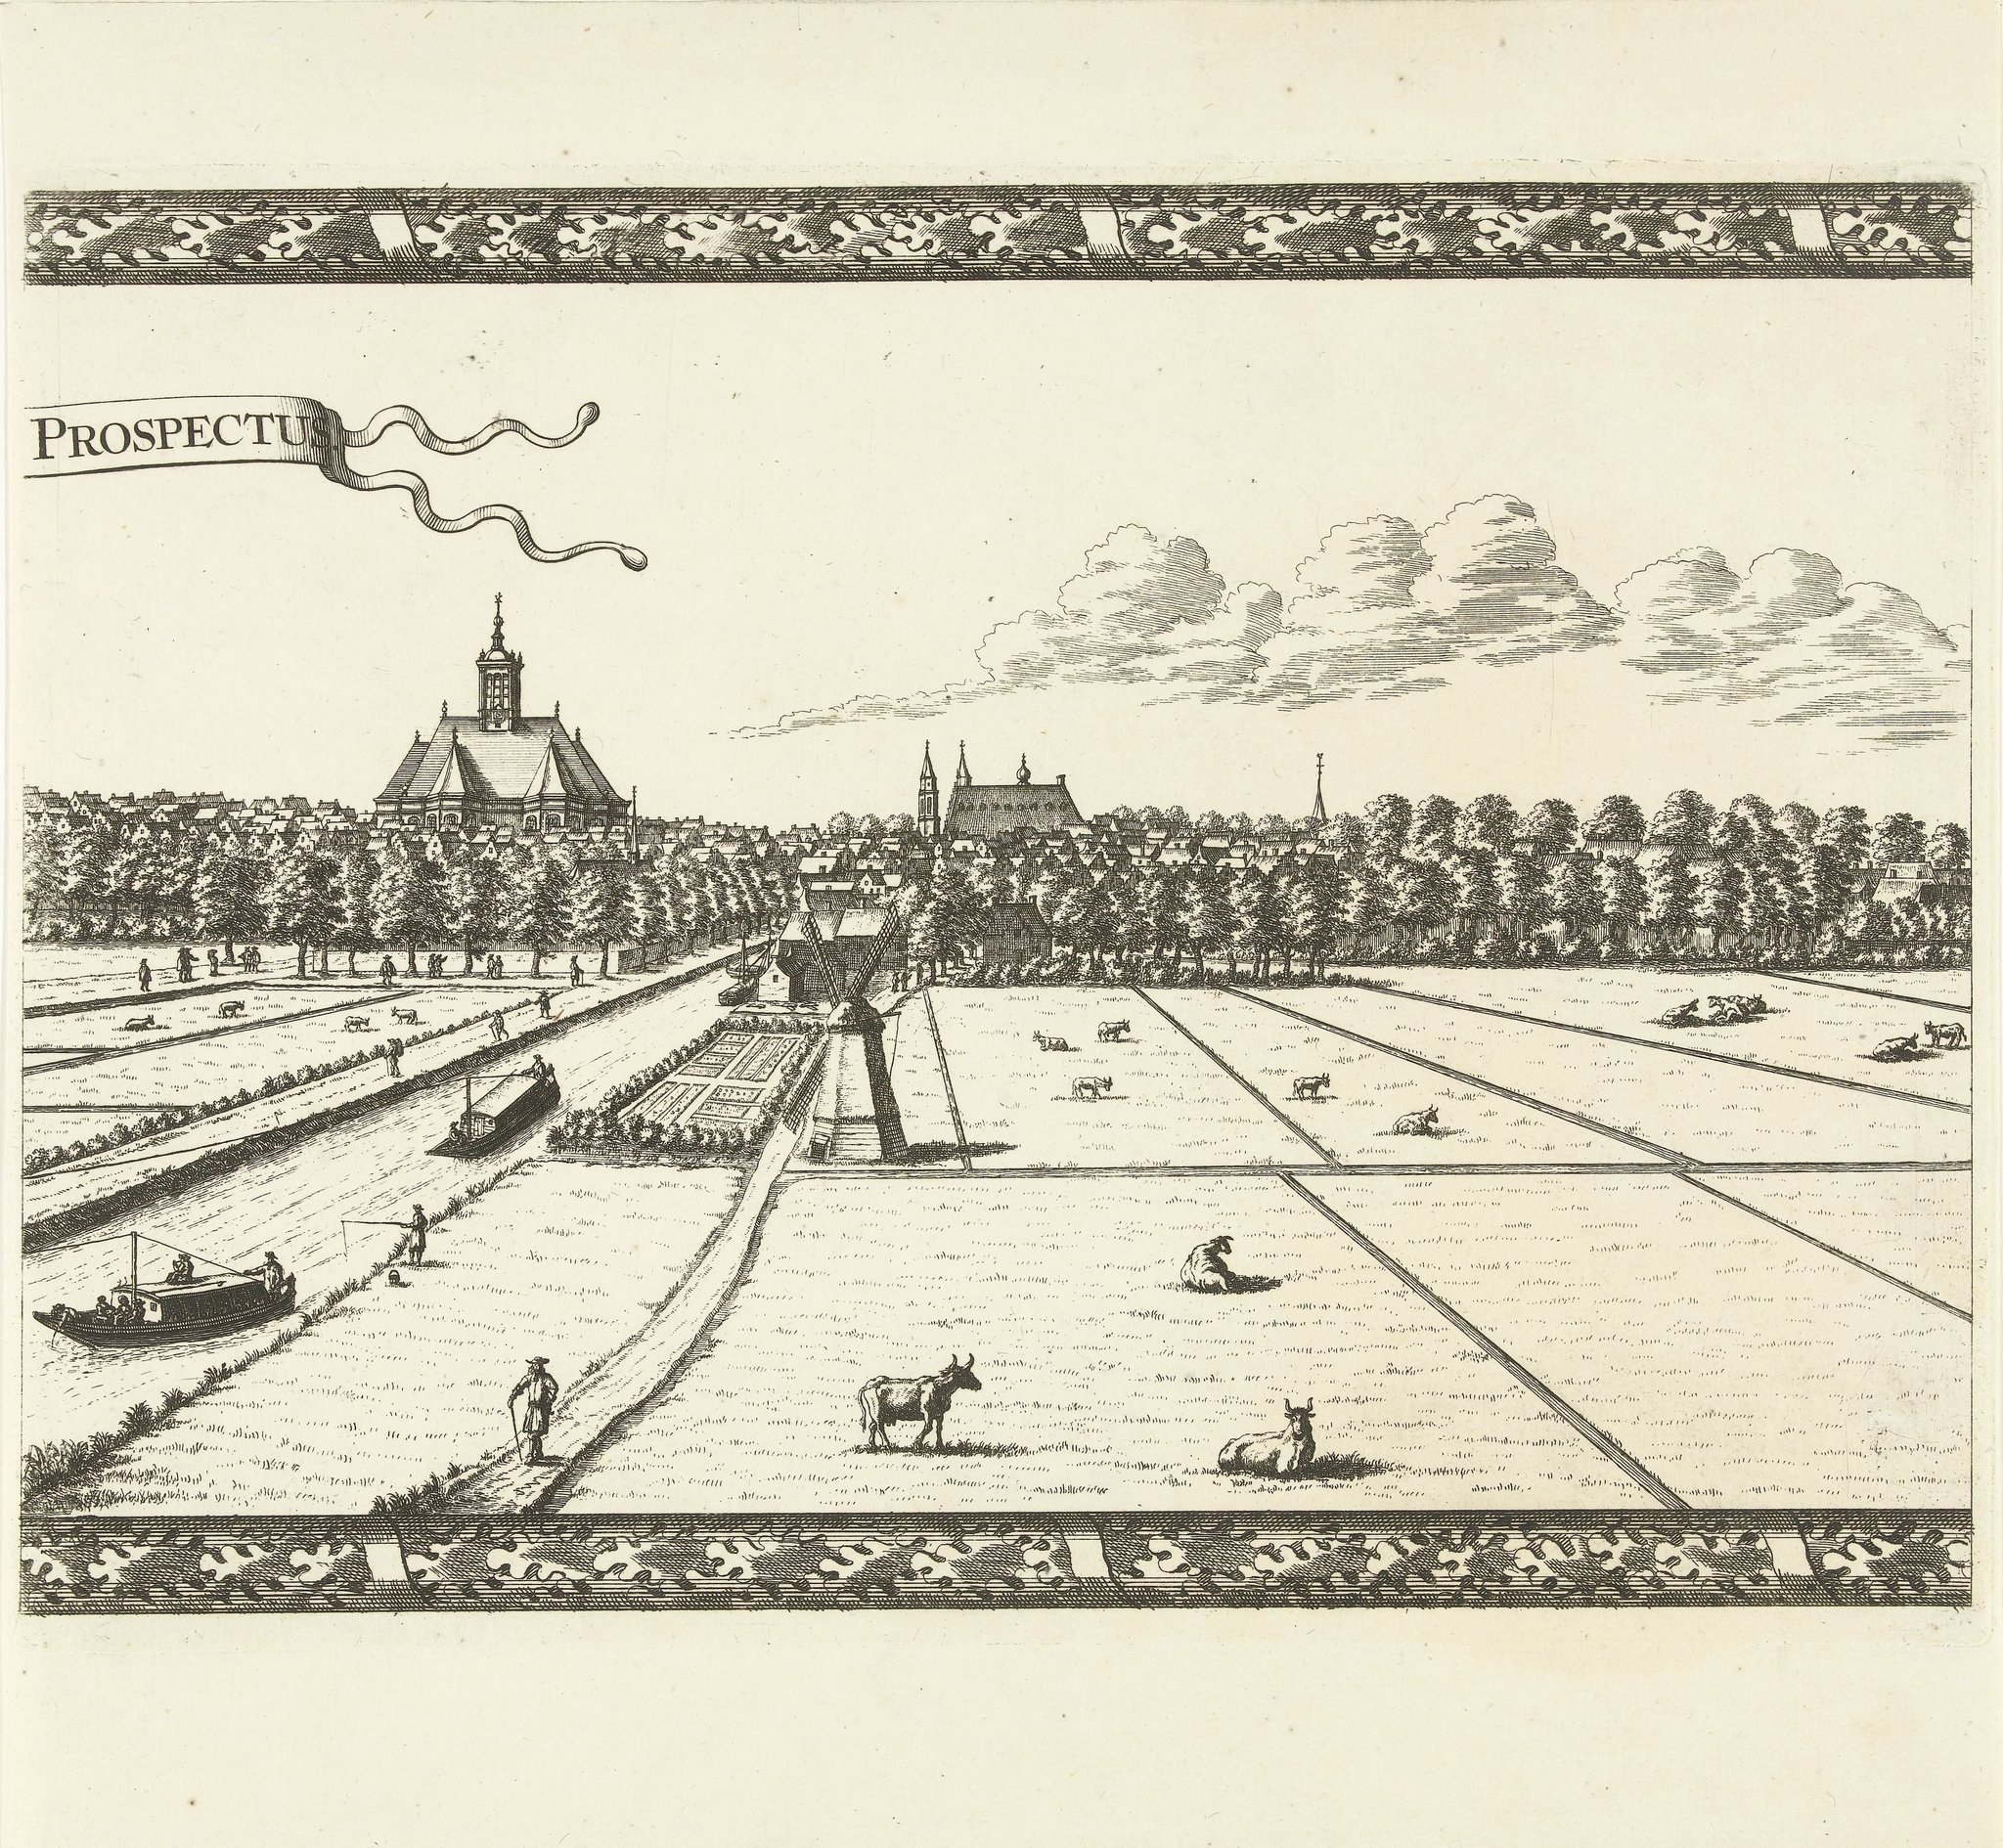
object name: print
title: Panoramisch gezicht op Den Haag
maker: cornelis elandts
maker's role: draughtsman, painter, print maker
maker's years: 1641-1687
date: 1663-1670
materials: paper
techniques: etching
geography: the hague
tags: the hague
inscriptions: collector's mark: Lugt 2228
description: Deze prent is oorspronkelijk uitgegeven als onderdeel van de rand van de zogenaamde figuratieve kaart van Den Haag uit 1681-1682 (zie RP-P-AO-12-9D). De rand bestond uit een gezicht op de stad en veertien kleinere gezichten in en om Den Haag. De vijftien prenten van de rand zijn later ook gebruikt in: Aa, Pieter van der. La galerie agreable du monde (...). 66 delen. Leiden: Pieter van der Aa, 1728, dl. 18 en 19. De huidige prent komt voor in dl. 19. De prenten van de rand zijn: RP-P-AO-12-8-2, RP-P-OB-50.201, RP-P-OB-50.202, RP-P-OB-50.203, RP-P-OB-50.204, RP-P-OB-50.205, RP-P-OB-50.206, RP-P-OB-50.207, RP-P-OB-50.208, RP-P-OB-50.209, RP-P-OB-50.210, RP-P-OB-50.211, RP-P-OB-50.212, RP-P-OB-50.213, en RP-P-OB-50.214.